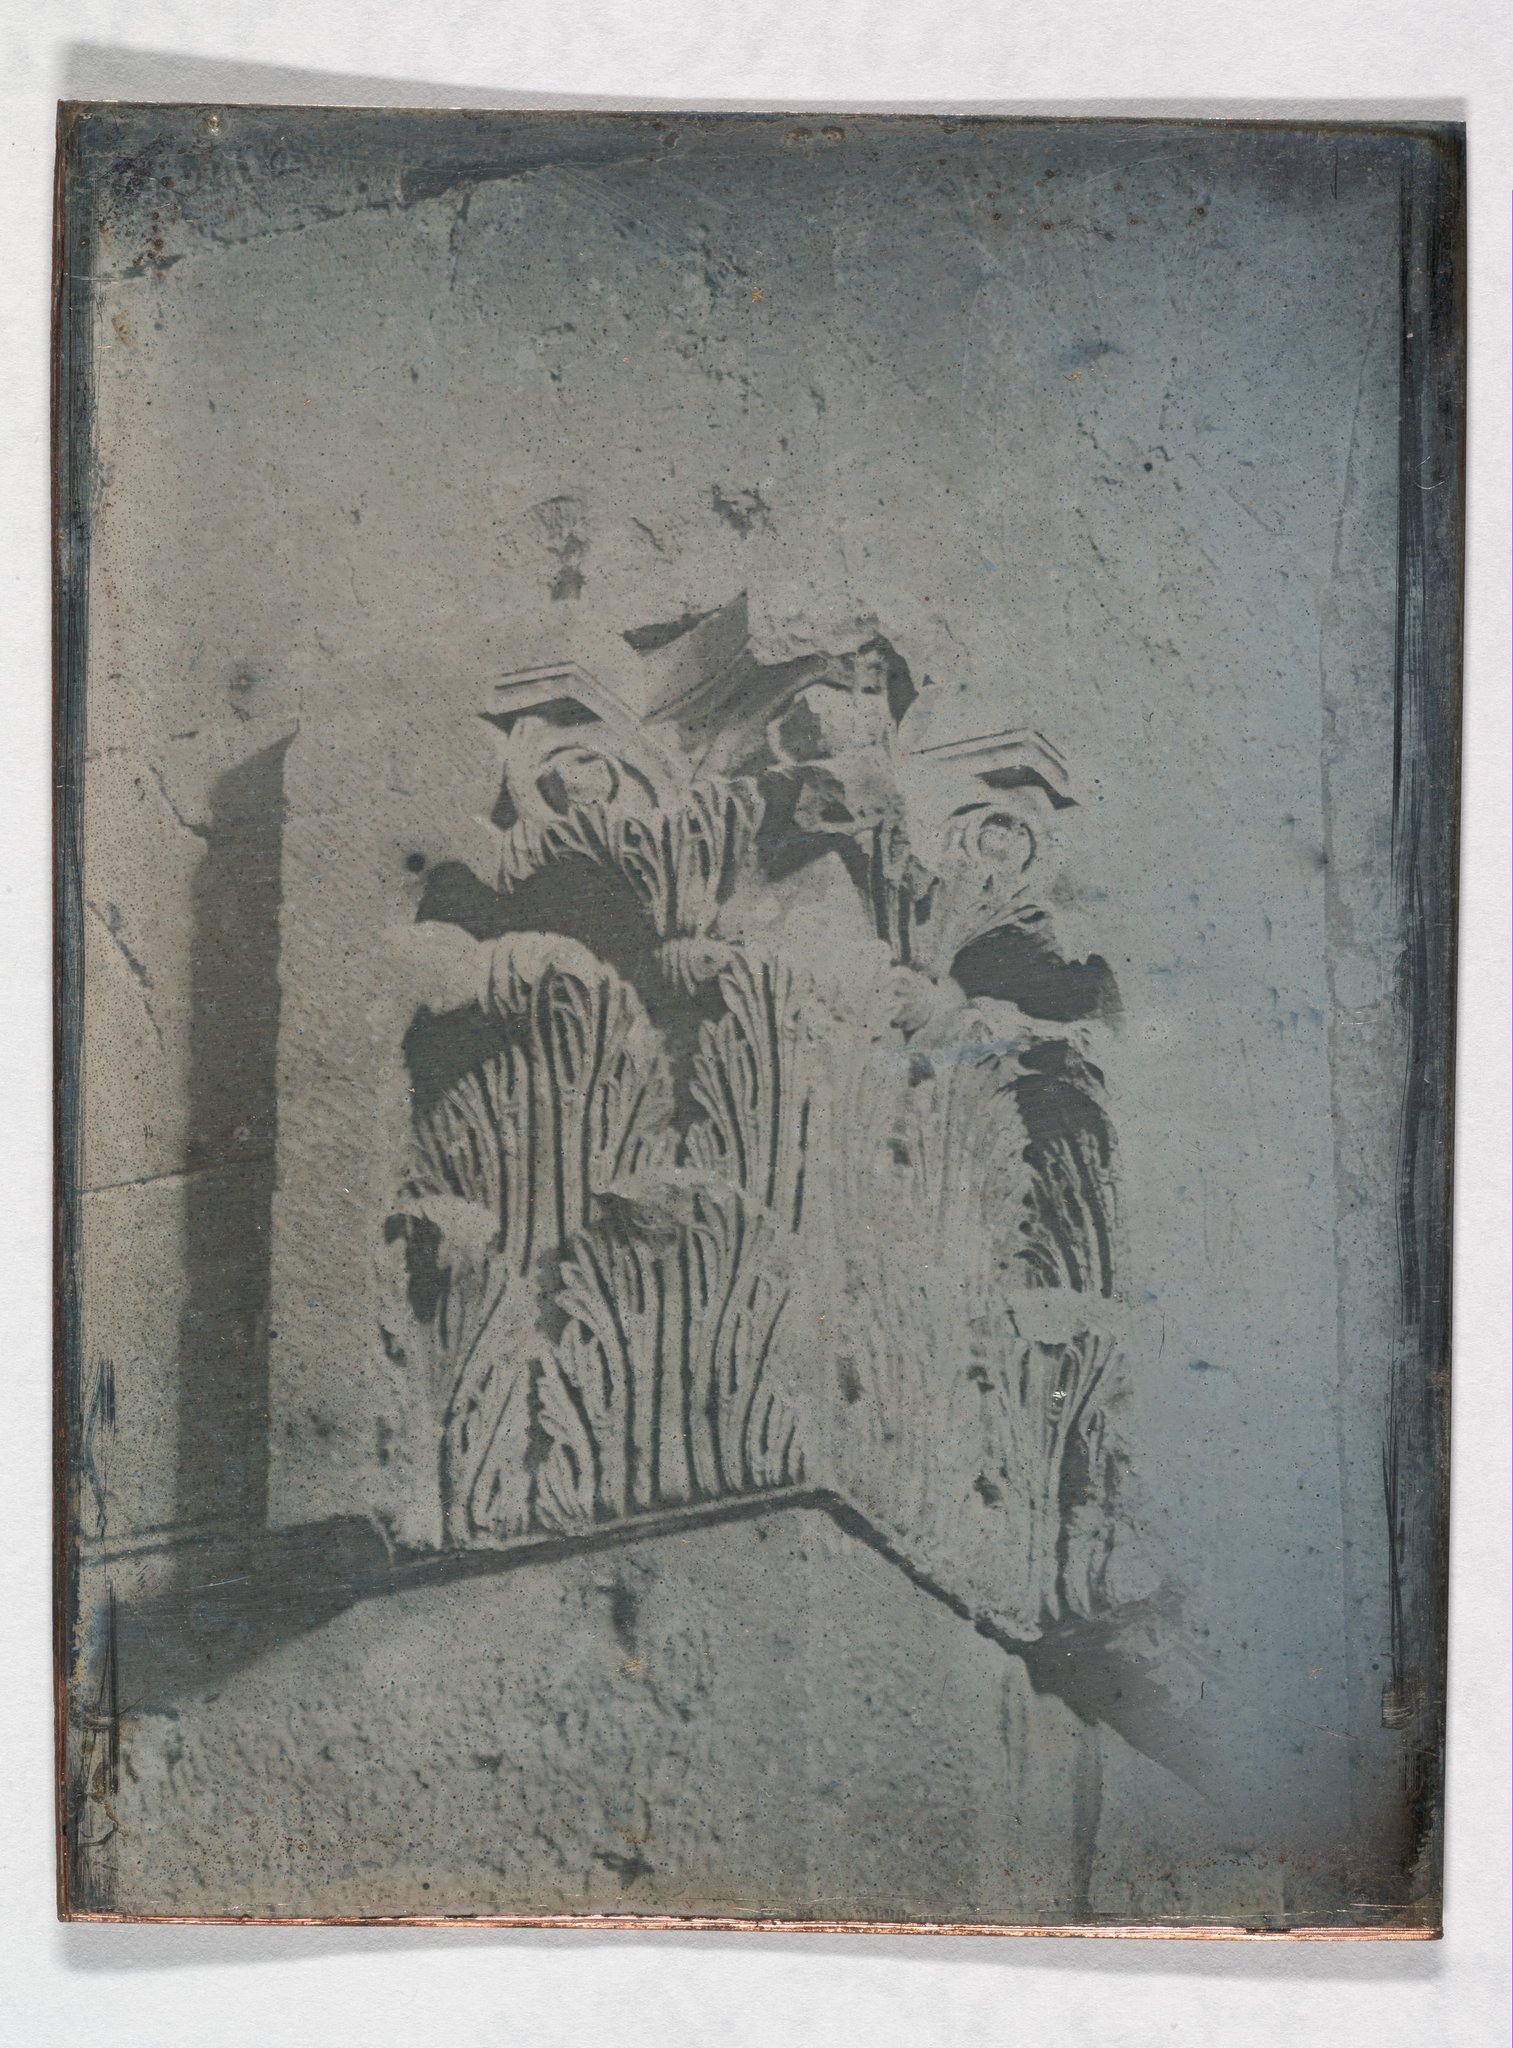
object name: photograph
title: Capital, near the Jaffa Gate, Jerusalem (184. Jerusalem, près de la porte de Jaffa. chap.)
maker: joseph-philibert girault de prangey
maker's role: artist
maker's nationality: french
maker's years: 1804-1892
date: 1844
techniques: daguerreotype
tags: architecture,capitals